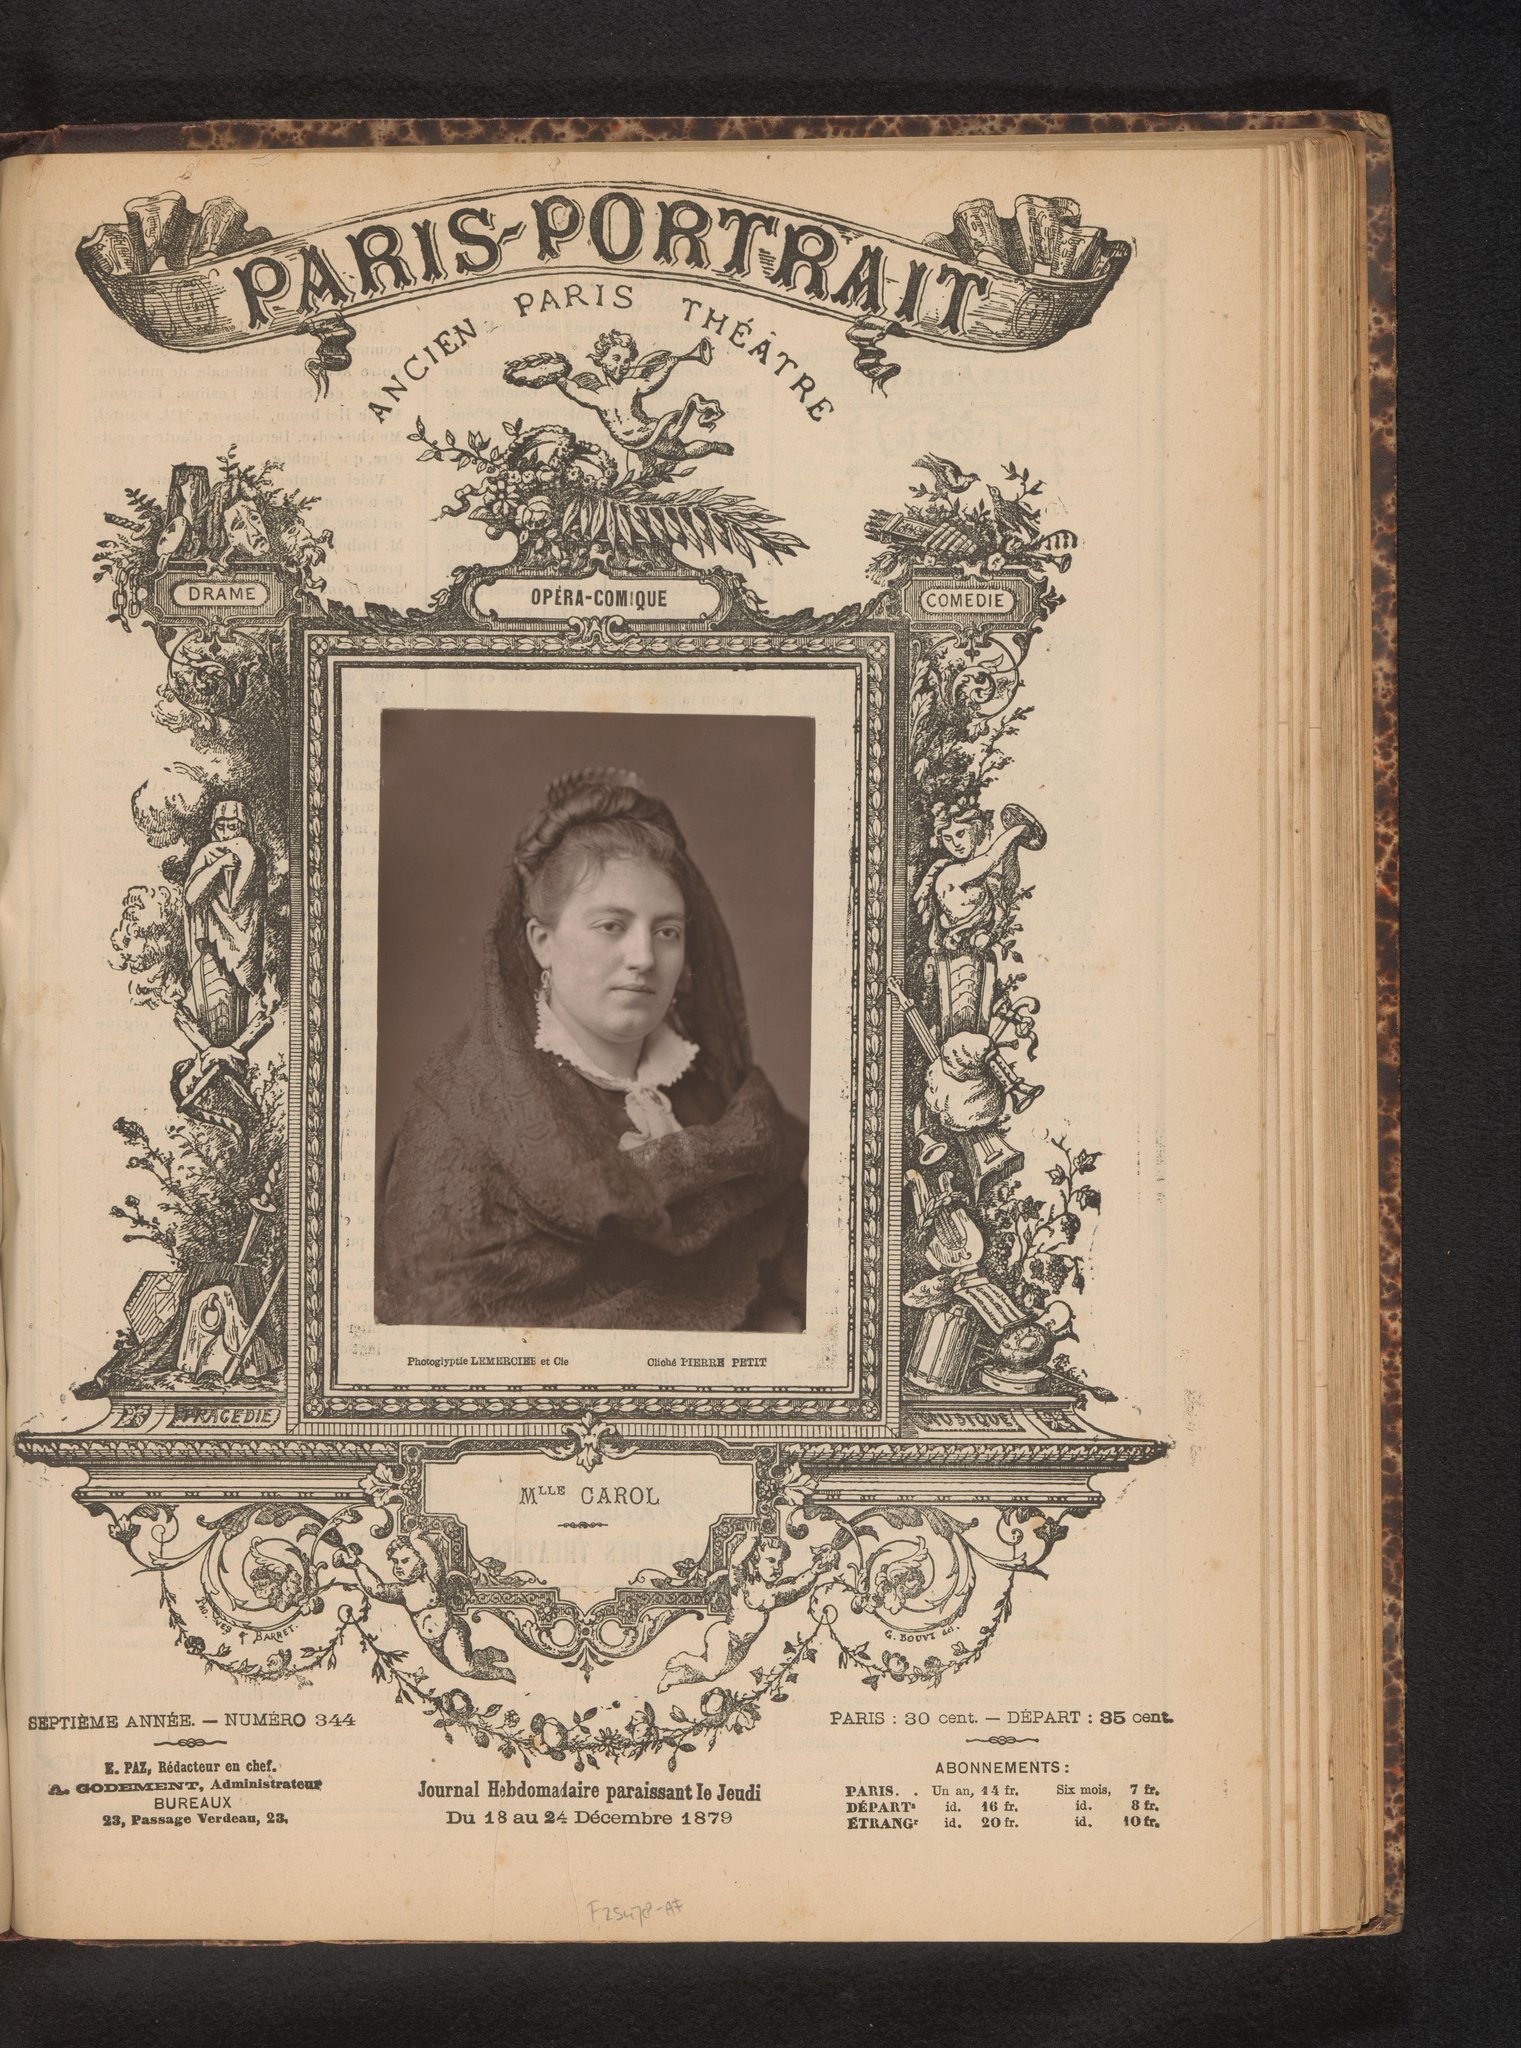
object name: photomechanical print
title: Mlle Carol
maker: pierre petit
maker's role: fotograaf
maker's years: 1832-1909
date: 1873-1880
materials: paper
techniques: woodburytype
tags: historical persons - bb - woman